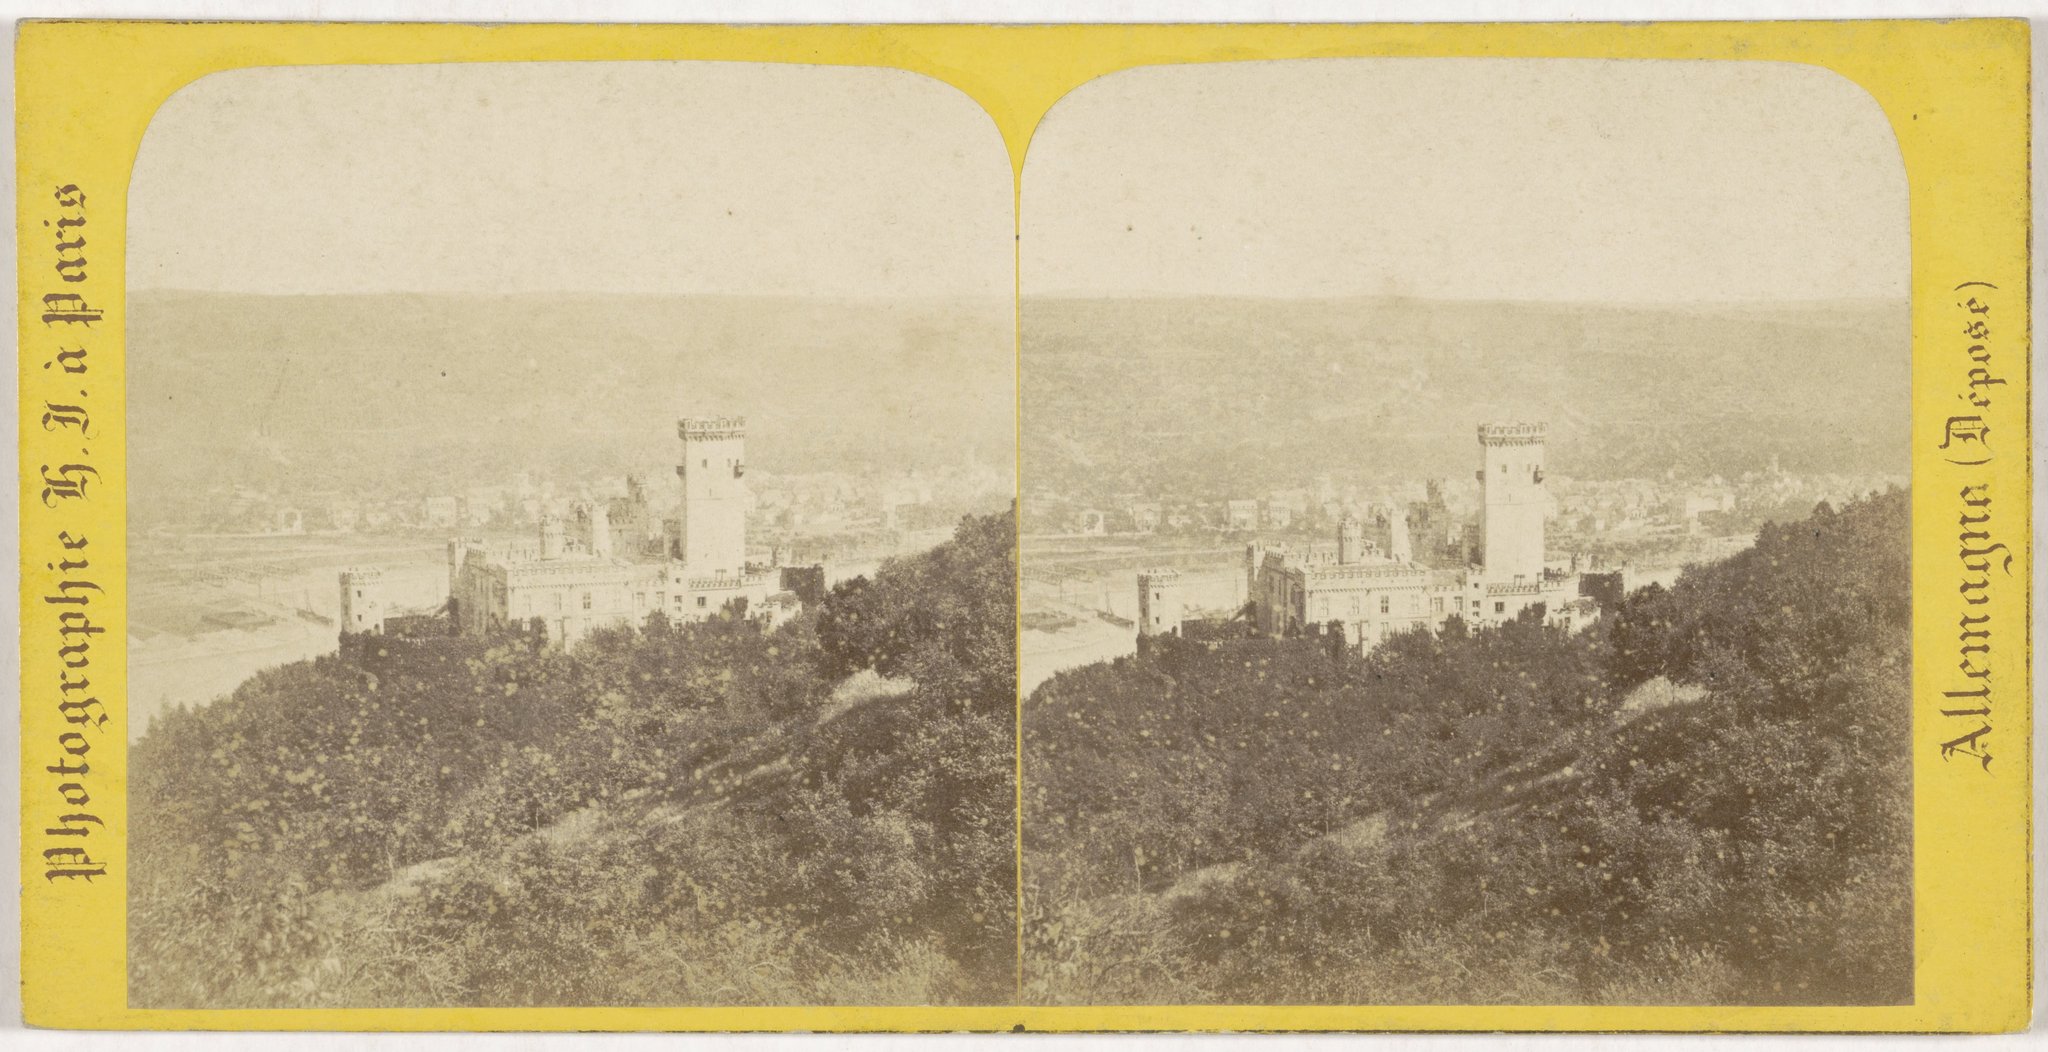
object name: stereograph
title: Allemagne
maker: hippolyte jouvin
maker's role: fotograaf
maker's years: 1825-1889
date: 1864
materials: cardboard, paper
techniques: albumen print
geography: koblenz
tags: landscape with tower or castle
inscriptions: inscription: ‘(Déposé)’, number: ‘N. 507’, inscription: ‘Déposé.’